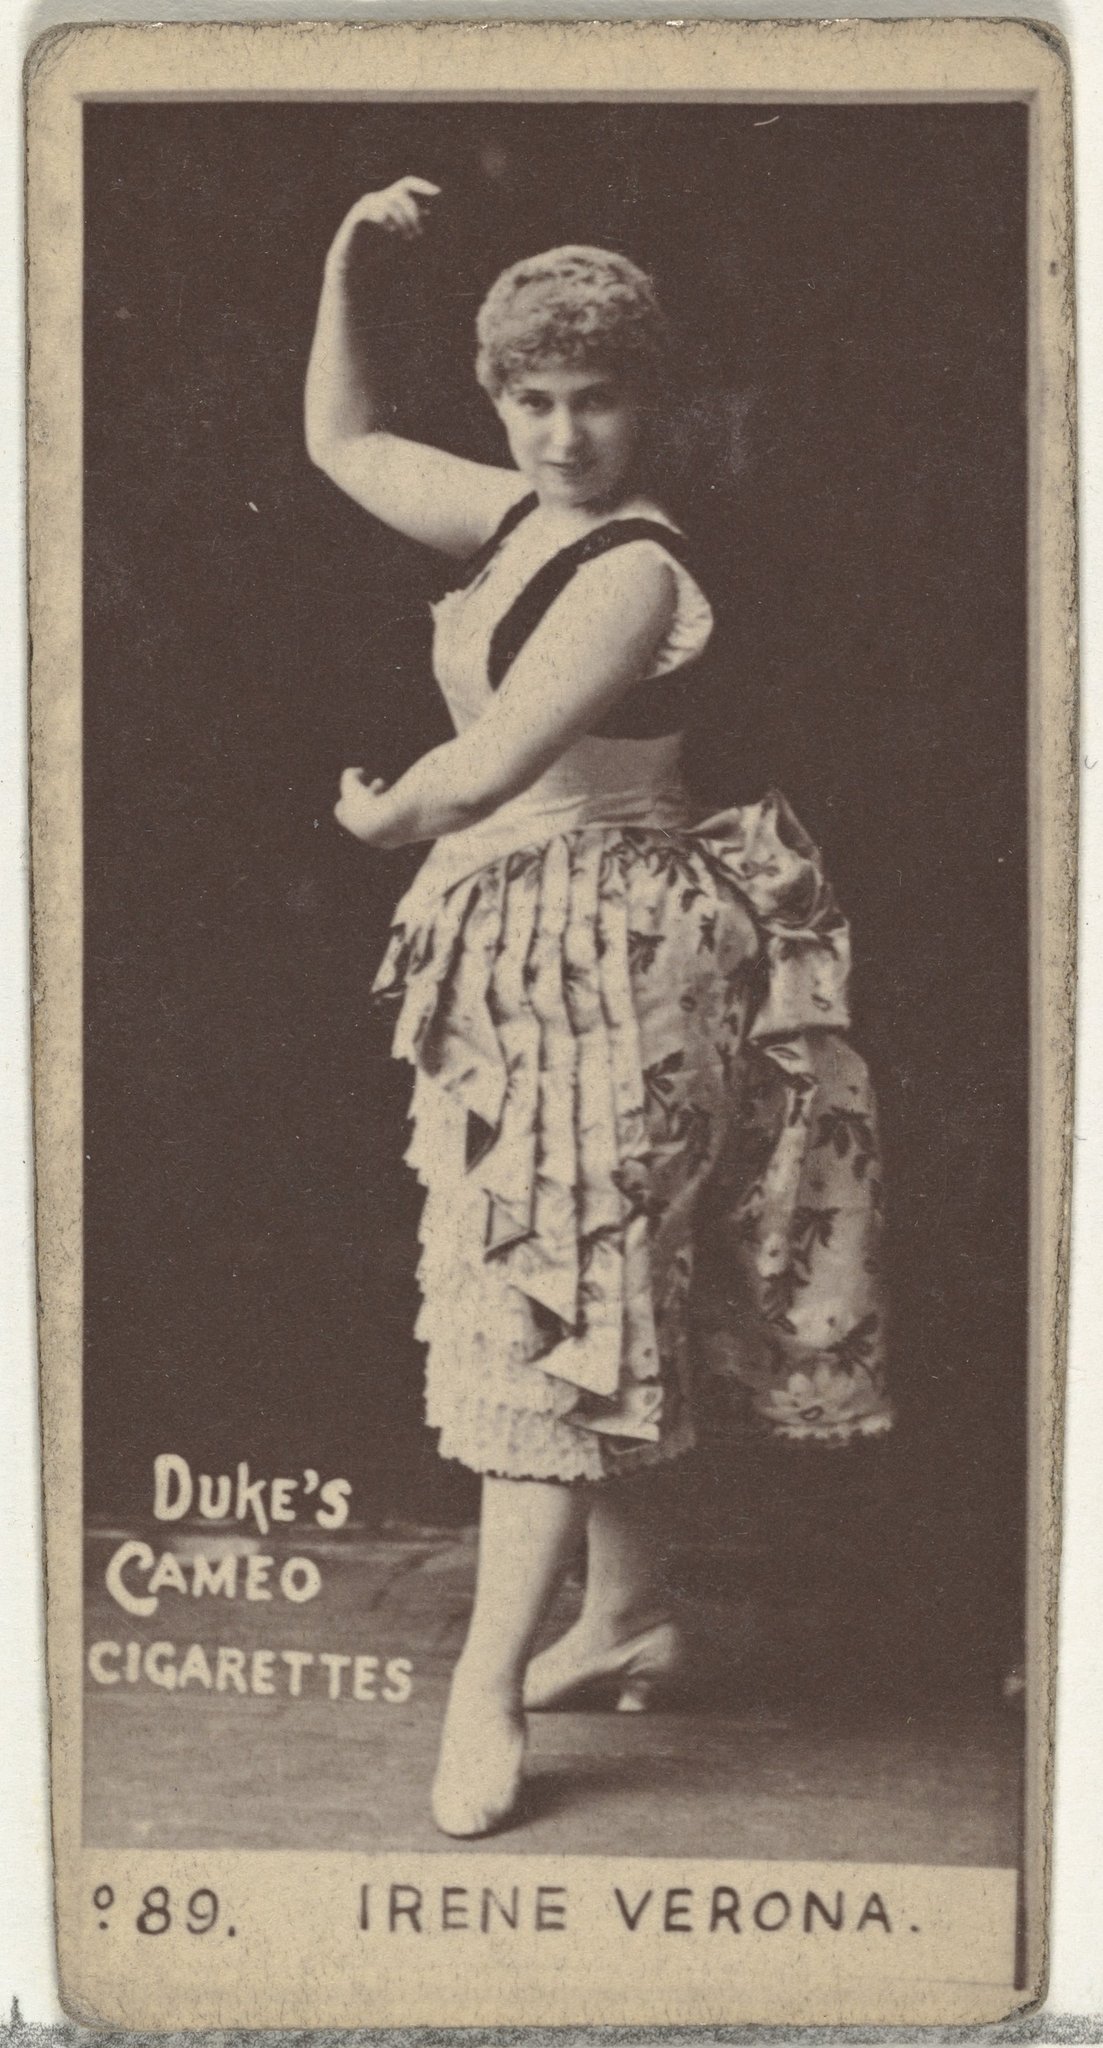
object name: photograph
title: Card Number 89, Irene Verona, from the Actors and Actresses series (N145-4) issued by Duke Sons & Co. to promote Cameo Cigarettes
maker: w. duke, sons & co.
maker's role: publisher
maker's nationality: american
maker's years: 1870-1920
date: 1880-1889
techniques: albumen silver print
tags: portraits,women,actresses